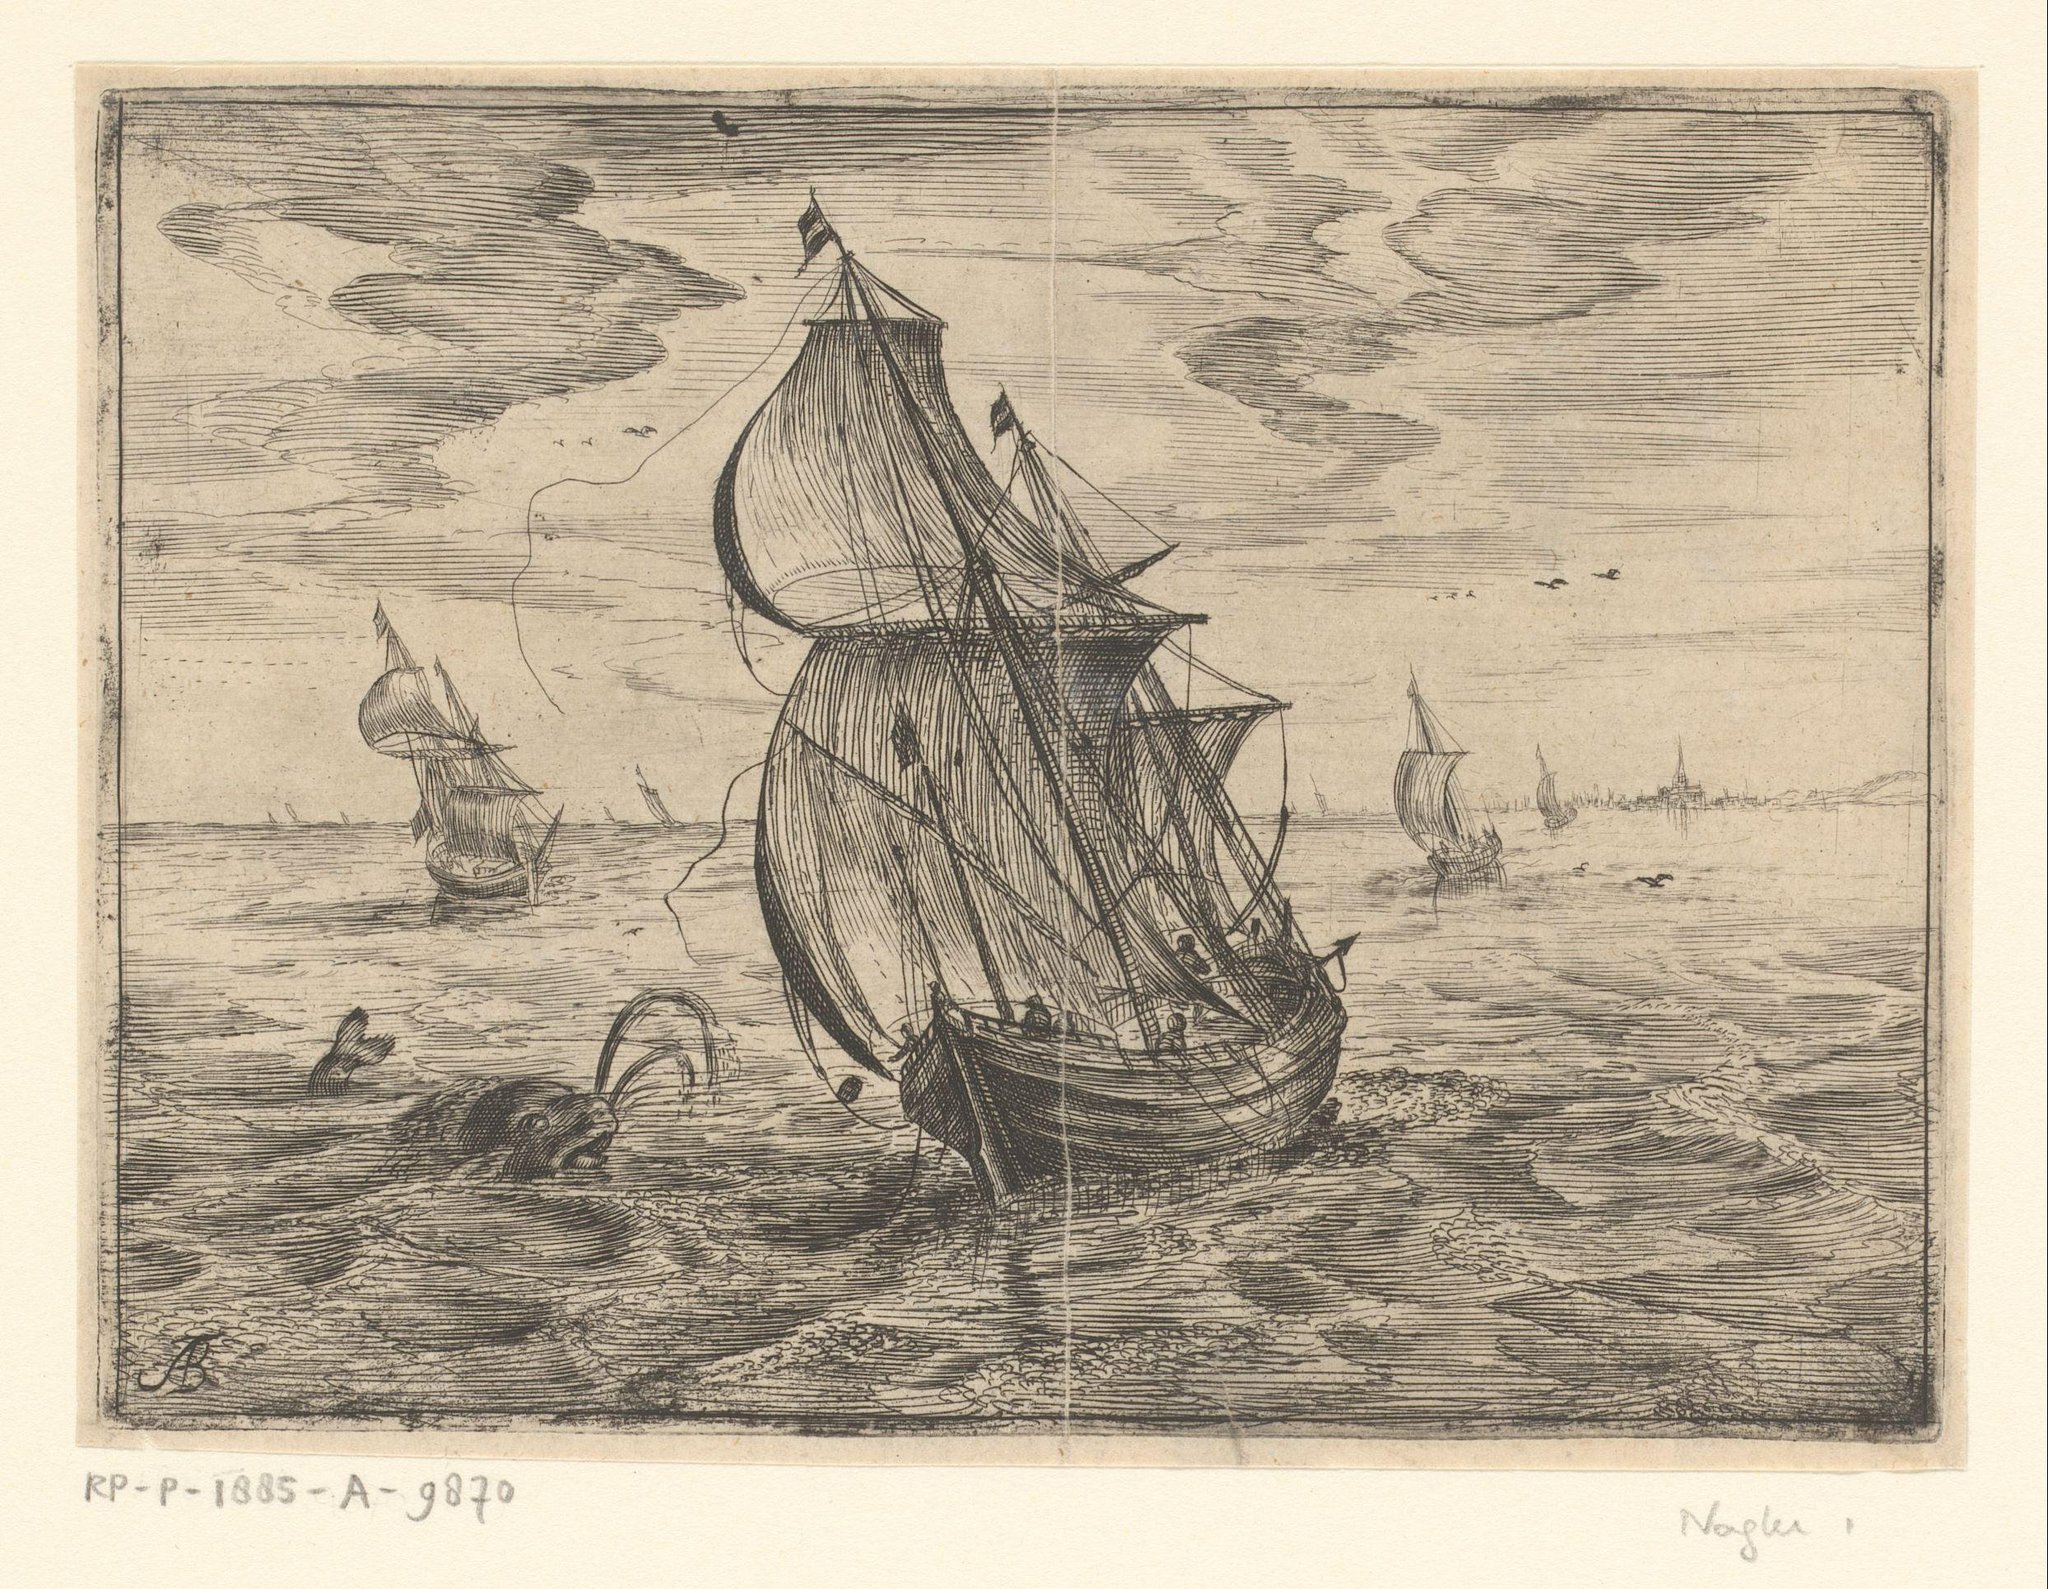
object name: print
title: Zeegezicht met zeilschepen en een walvis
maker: monogrammist ab (17e eeuw)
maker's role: print maker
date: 1650-1700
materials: paper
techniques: etching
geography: low countries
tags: sailing-ship, sailing-boat, sea (seascape), swimming mammals: whale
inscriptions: collector's mark: Lugt 2228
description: Enkele zeilschepen op open water. Vooraan gooit een man een ton van het schip af. Links een walvis. Rechts in de verte de kustlijn met een stadsgezicht.